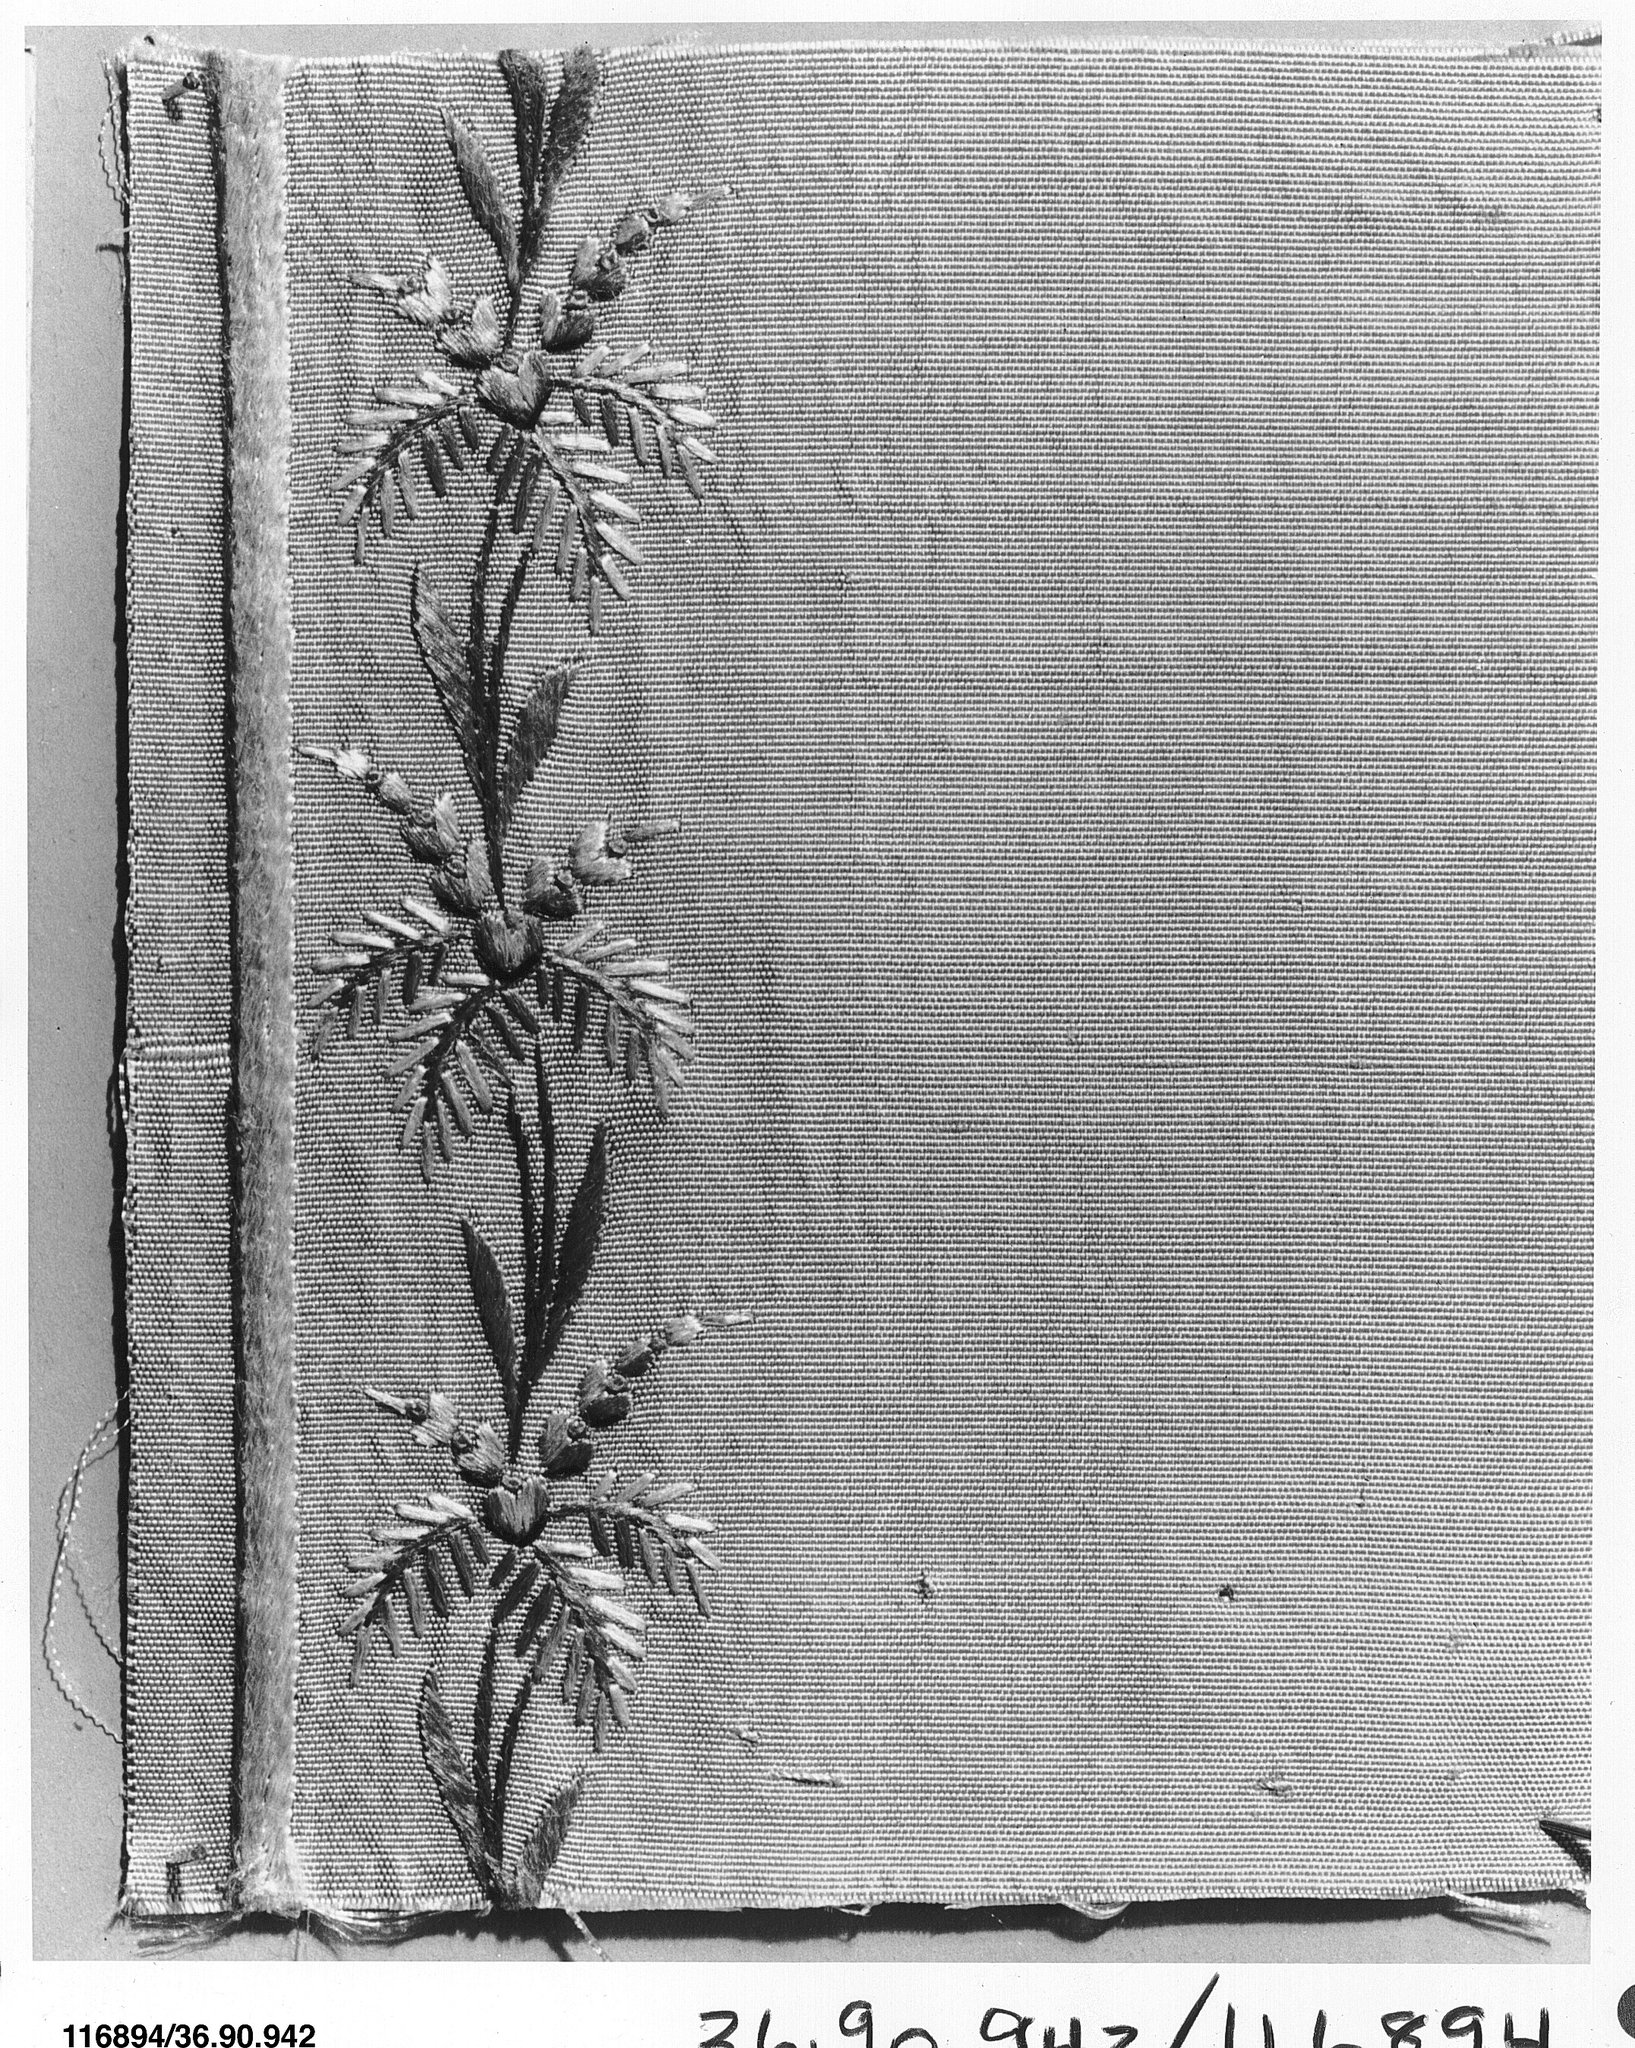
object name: sample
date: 1801-1833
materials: silk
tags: flowers